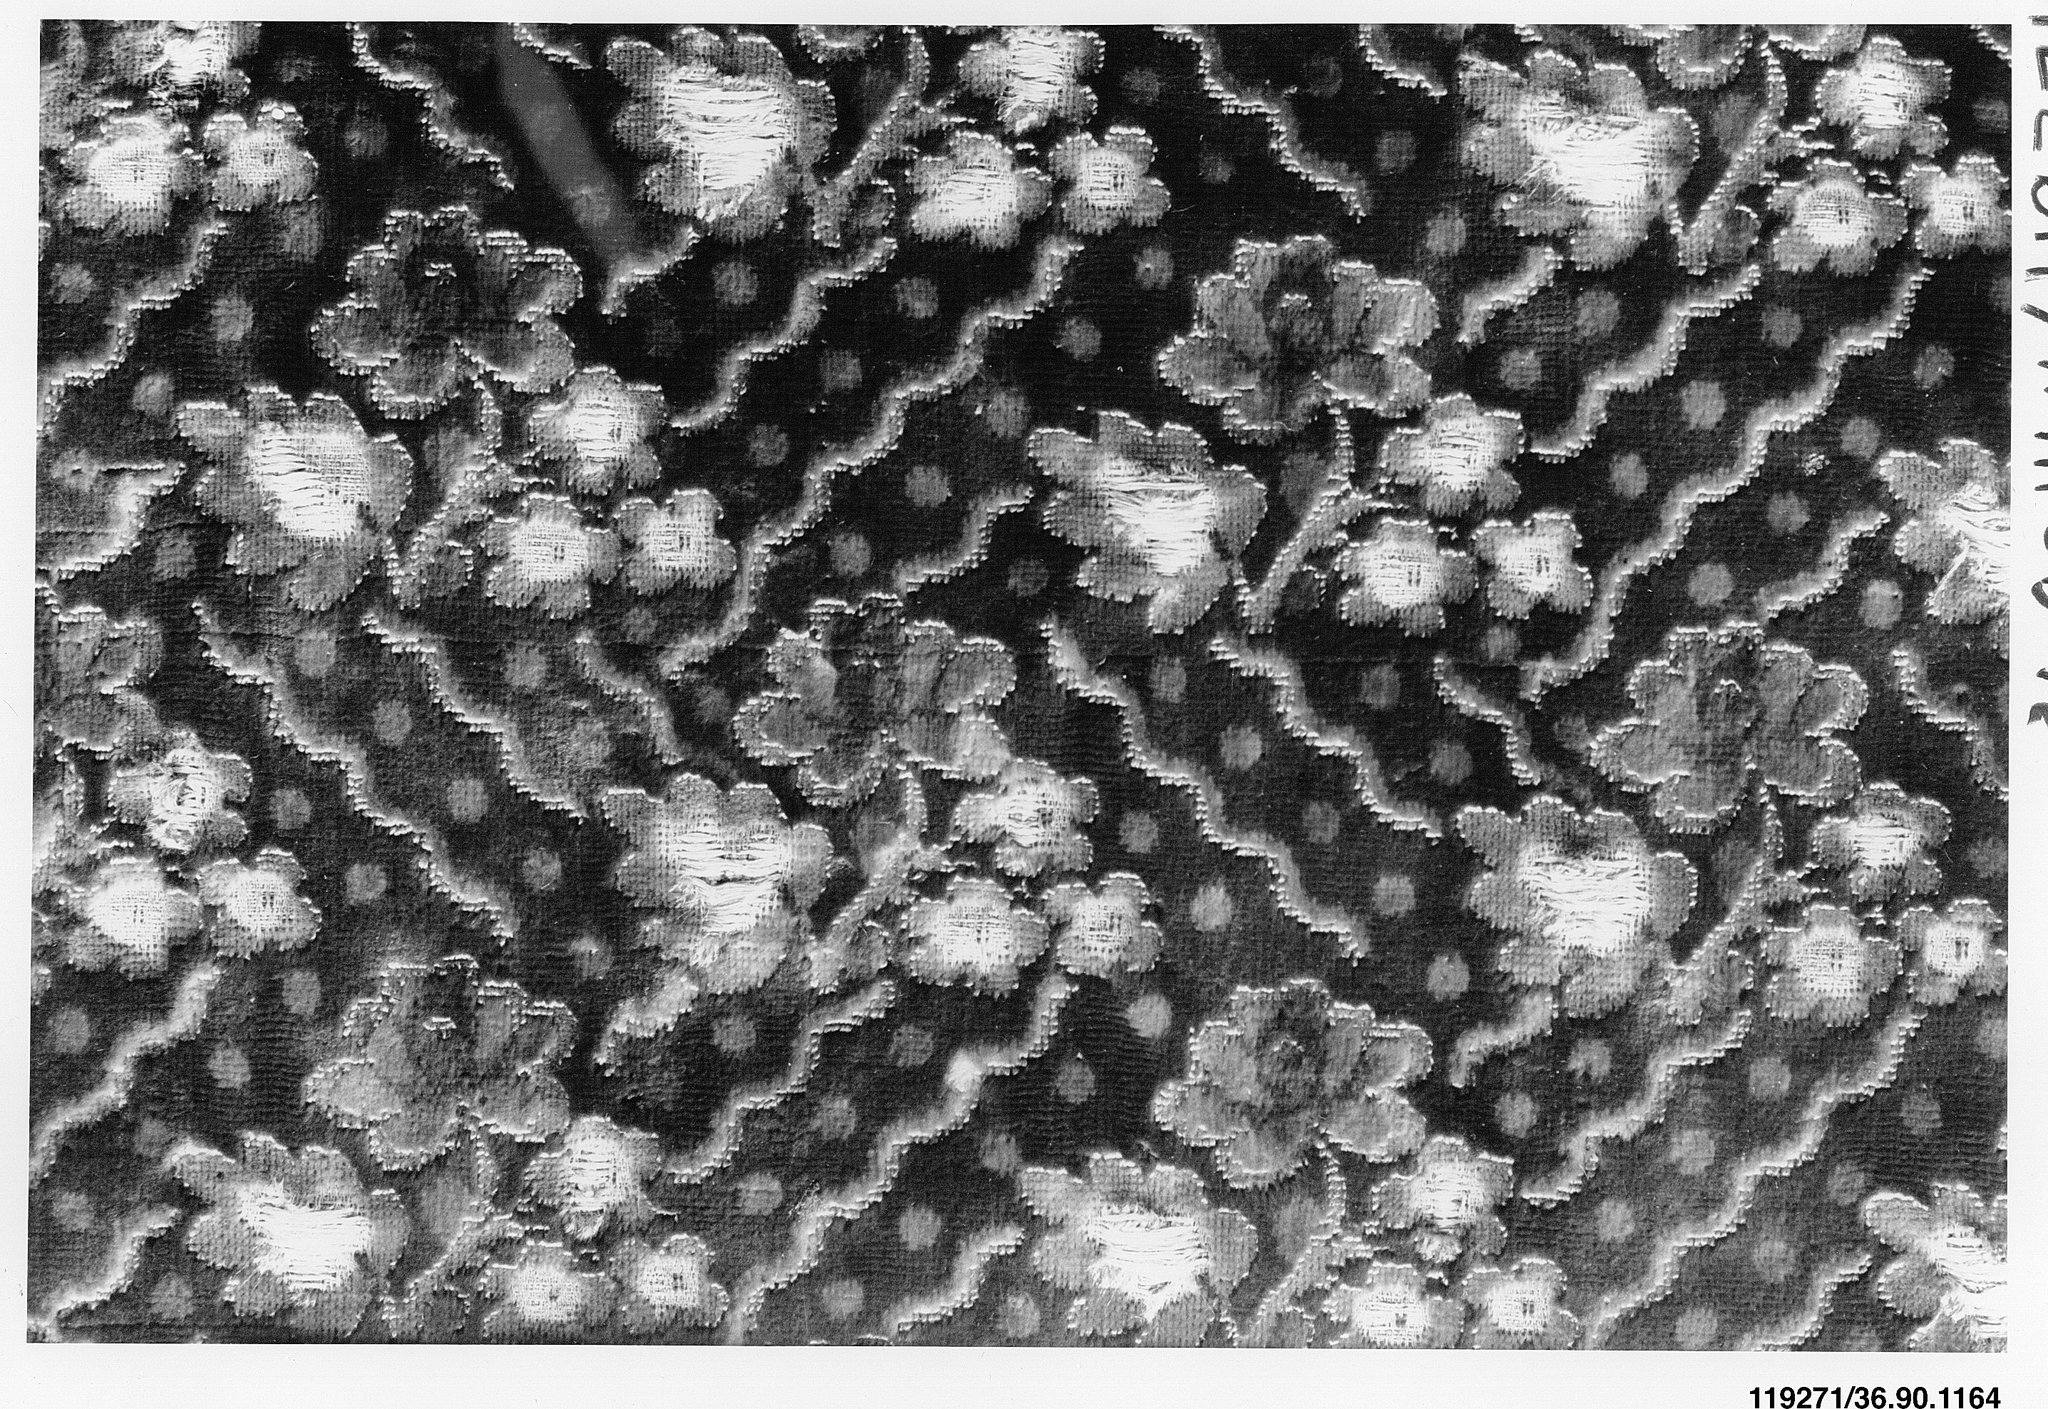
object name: piece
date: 1701-1800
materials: silk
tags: flowers